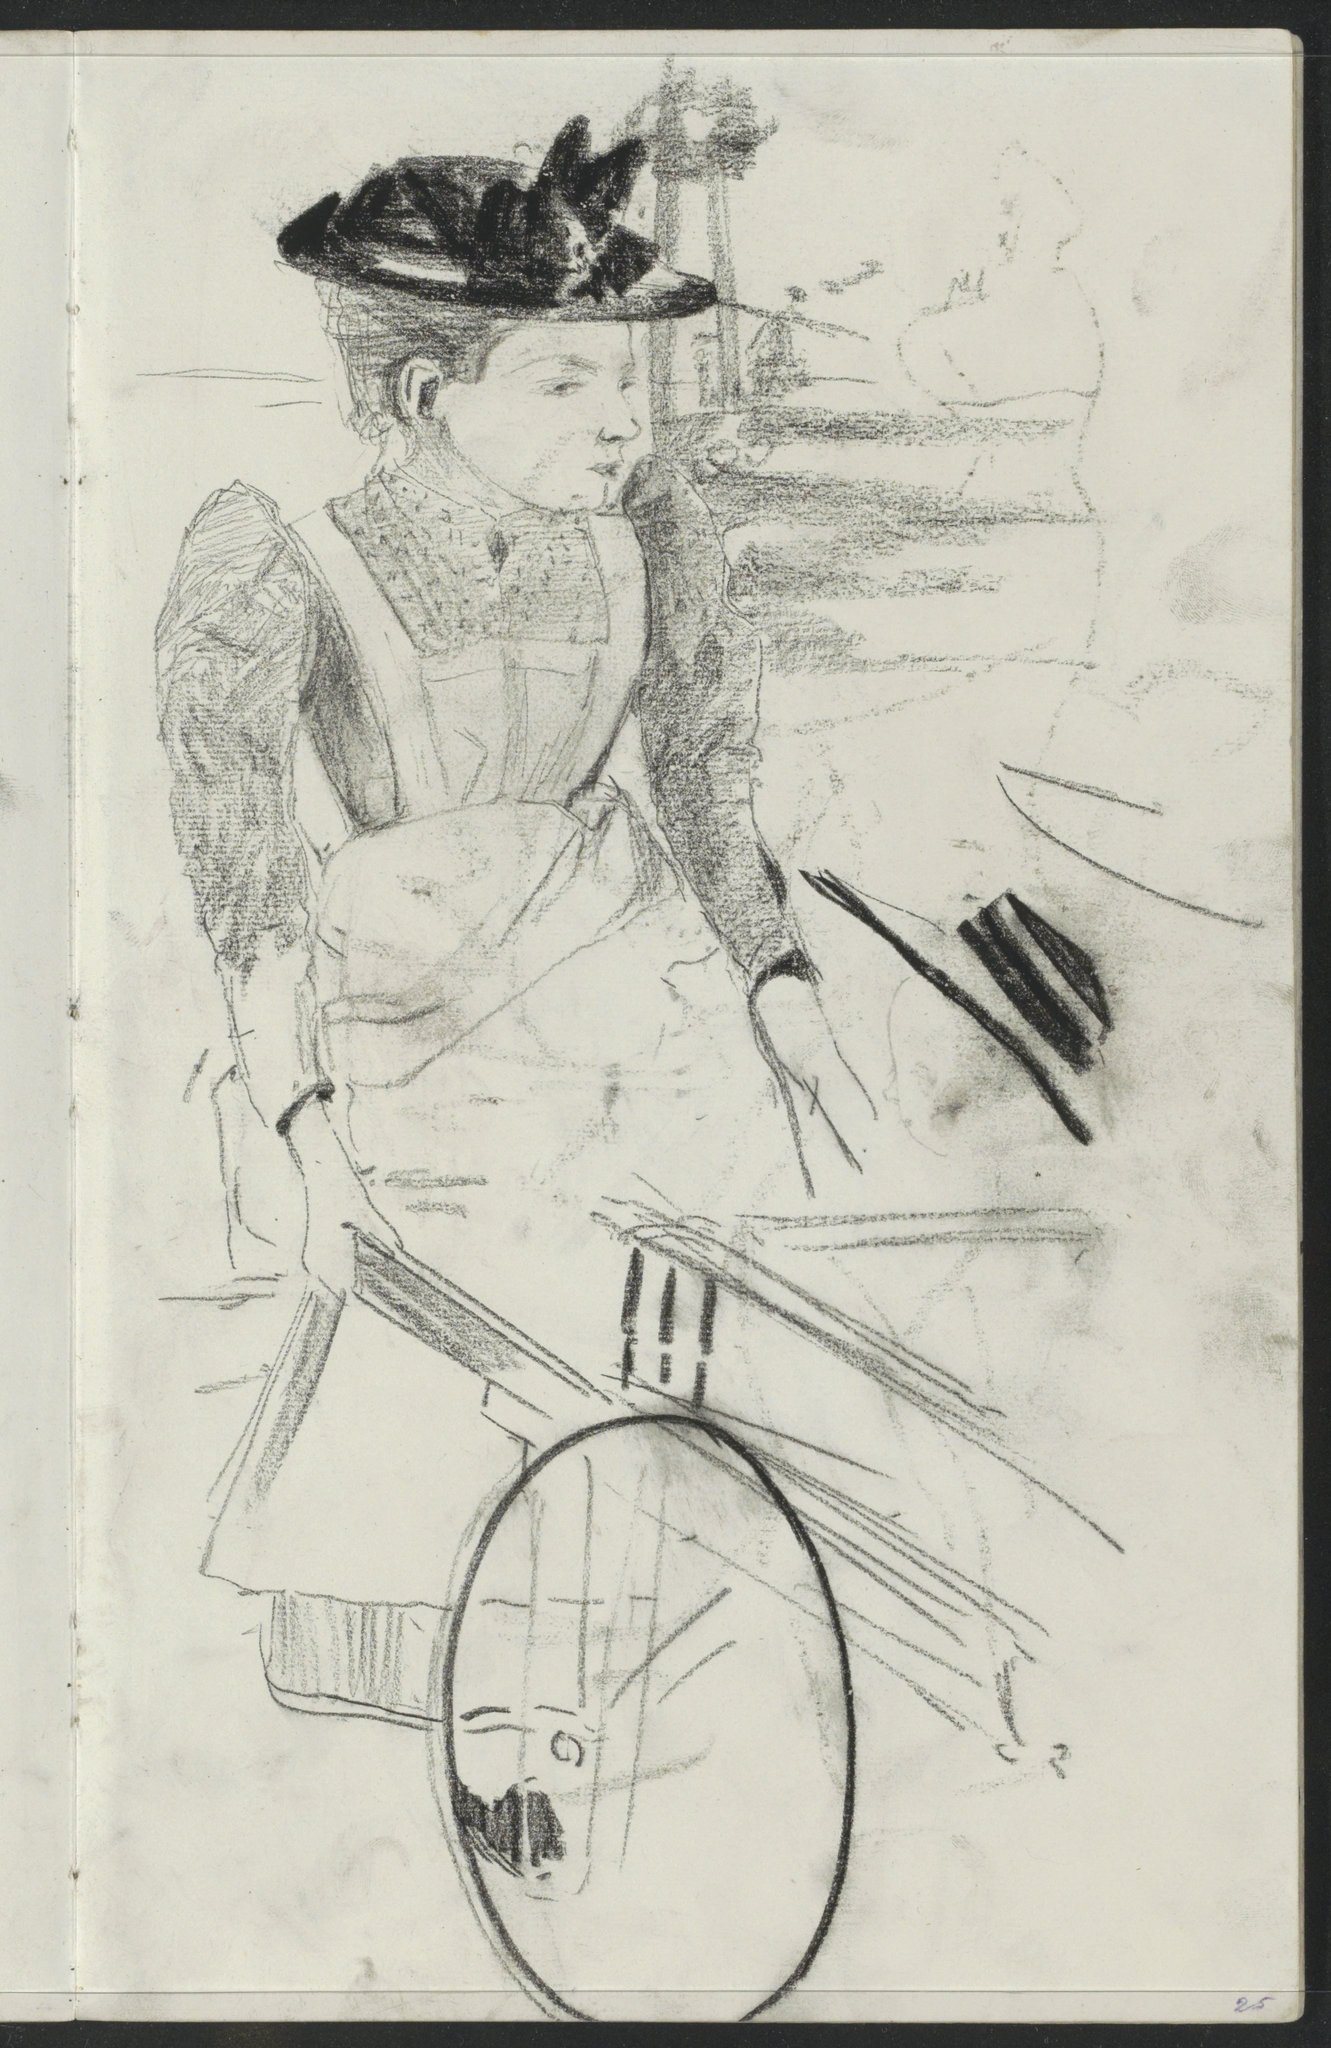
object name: sketchbook leaf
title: Vrouw met een kind op een kar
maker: isaac israels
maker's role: draughtsman, painter, print maker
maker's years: 1865-1934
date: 1875-1934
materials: chalk, paper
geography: amsterdam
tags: park, mother and child(ren), woman and child(ren) (family group)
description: Mogelijk in het Oosterpark te Amsterdam. Blad 25 recto uit schetsboek XI met 30 bladen.